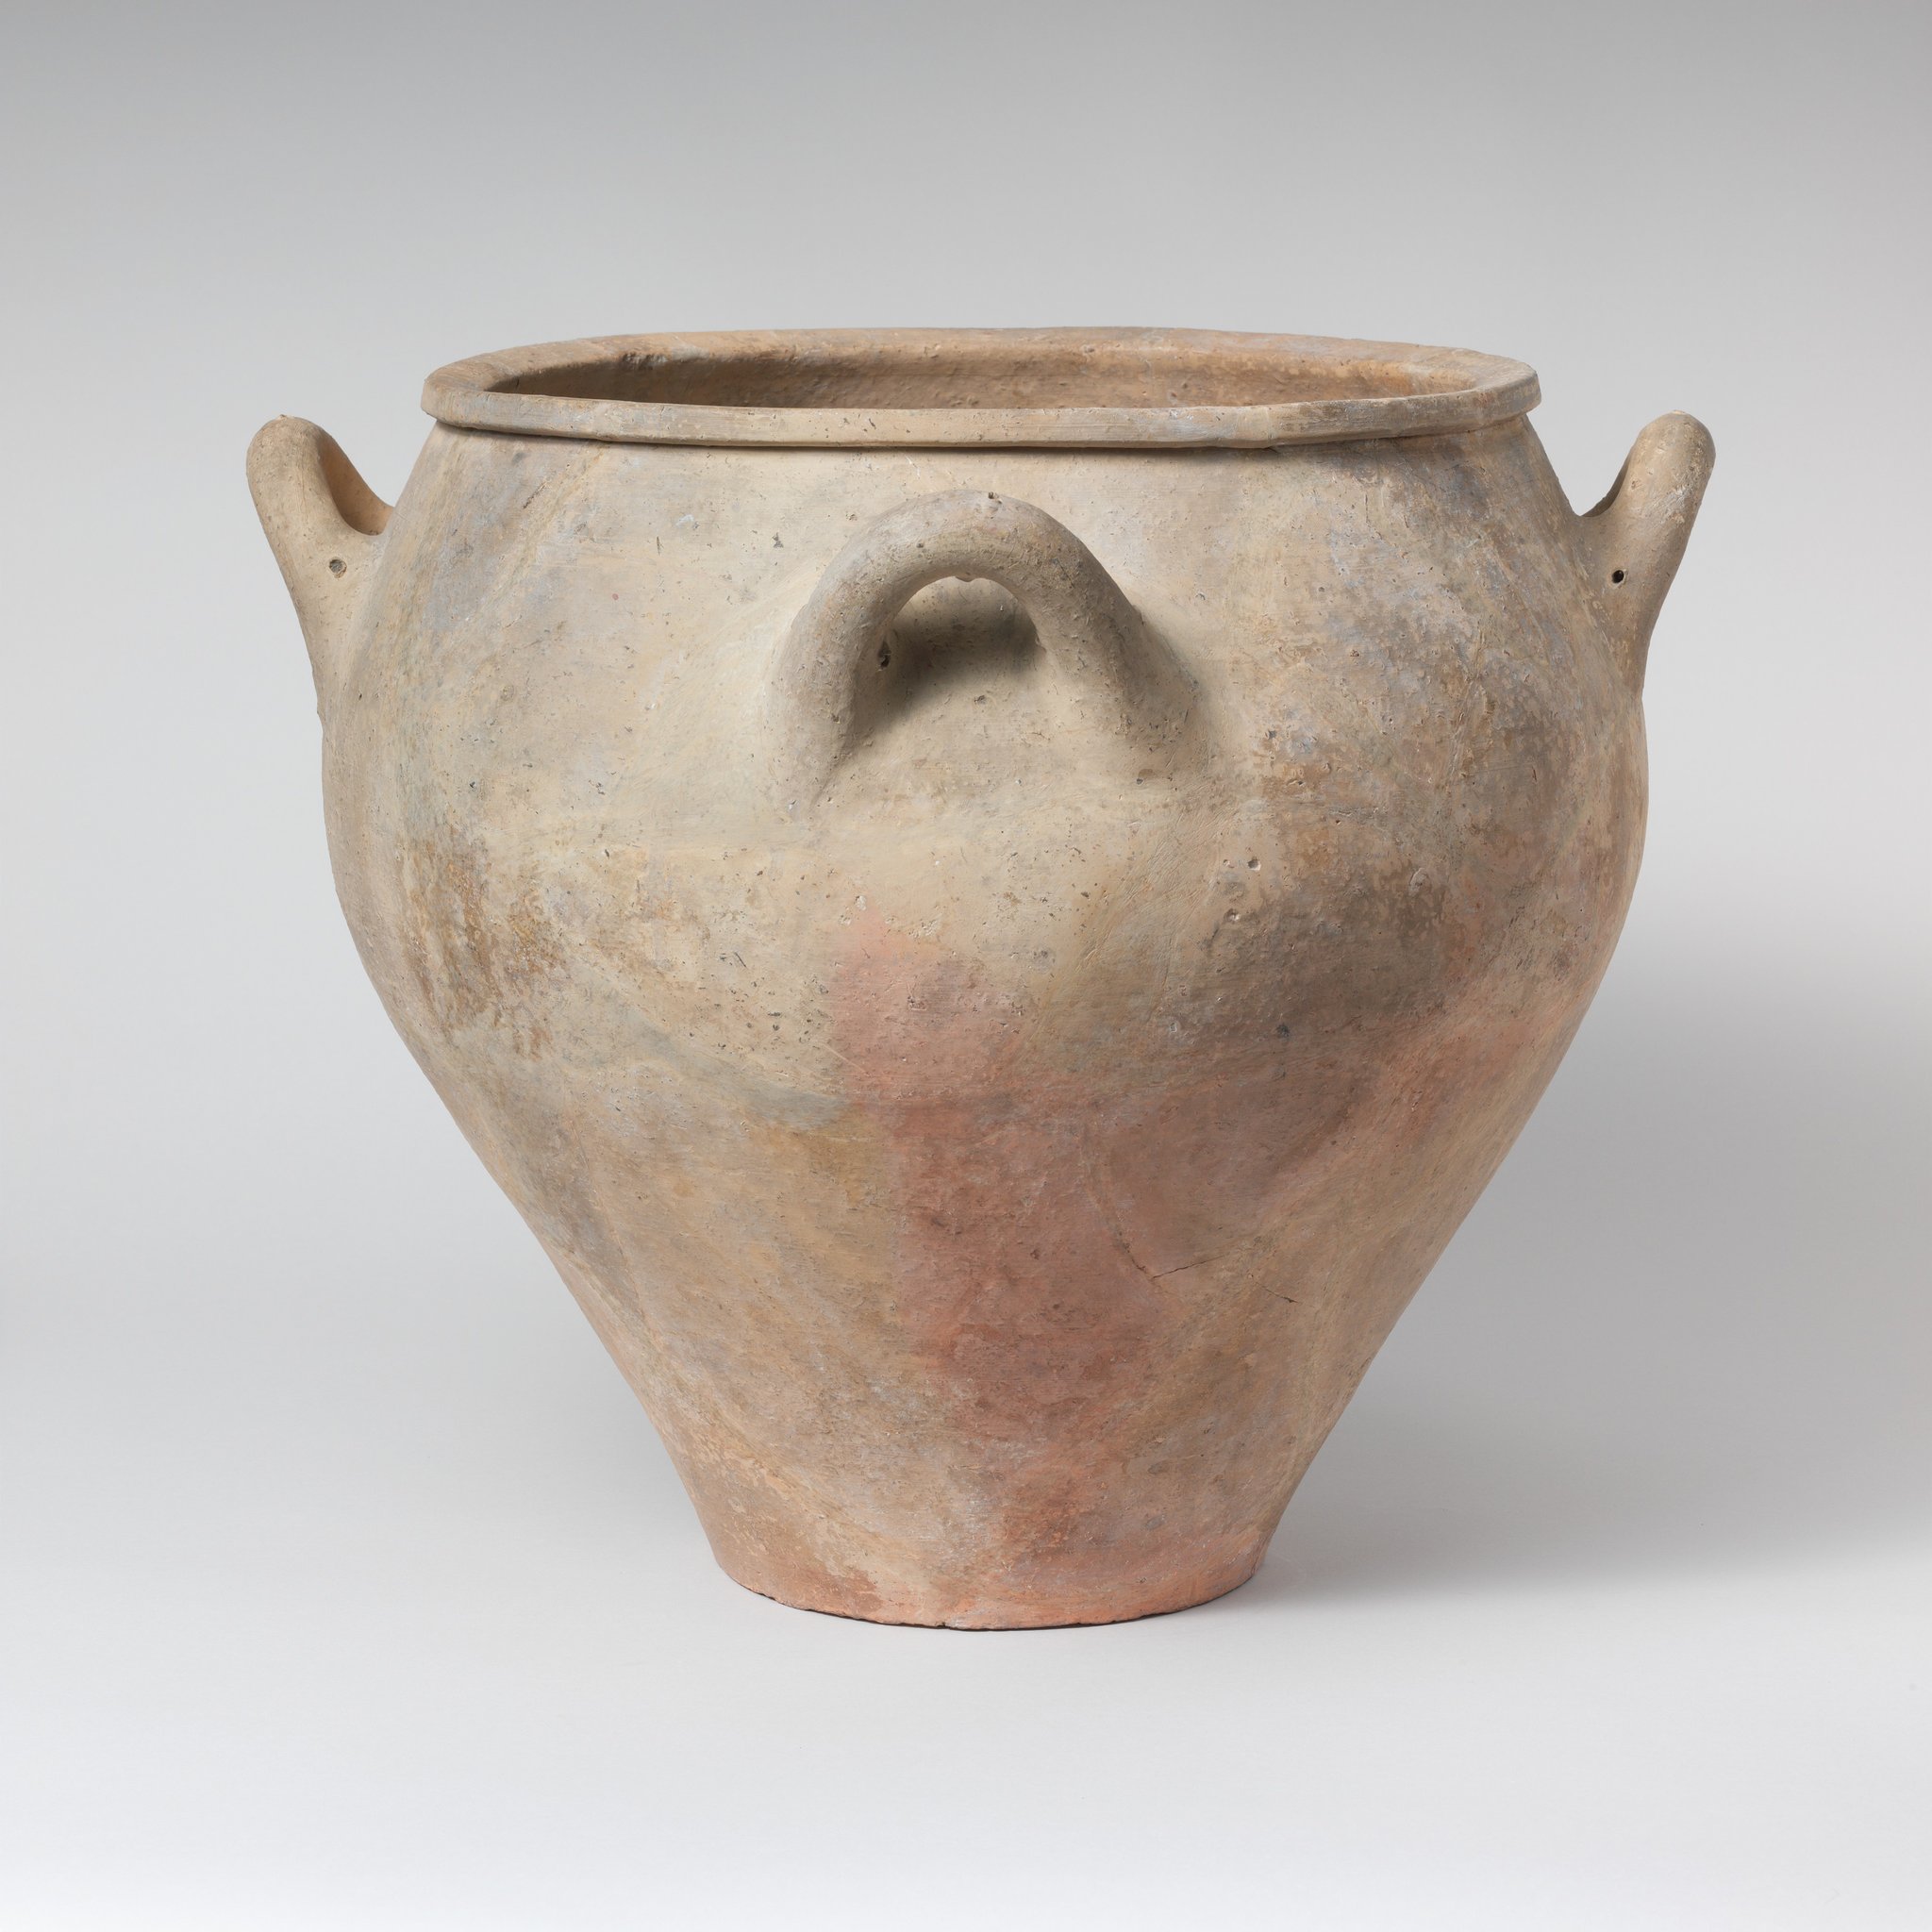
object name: krater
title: Terracotta krater (deep bowl) with four handles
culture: mycenaean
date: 1400-1190 BCE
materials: terracotta